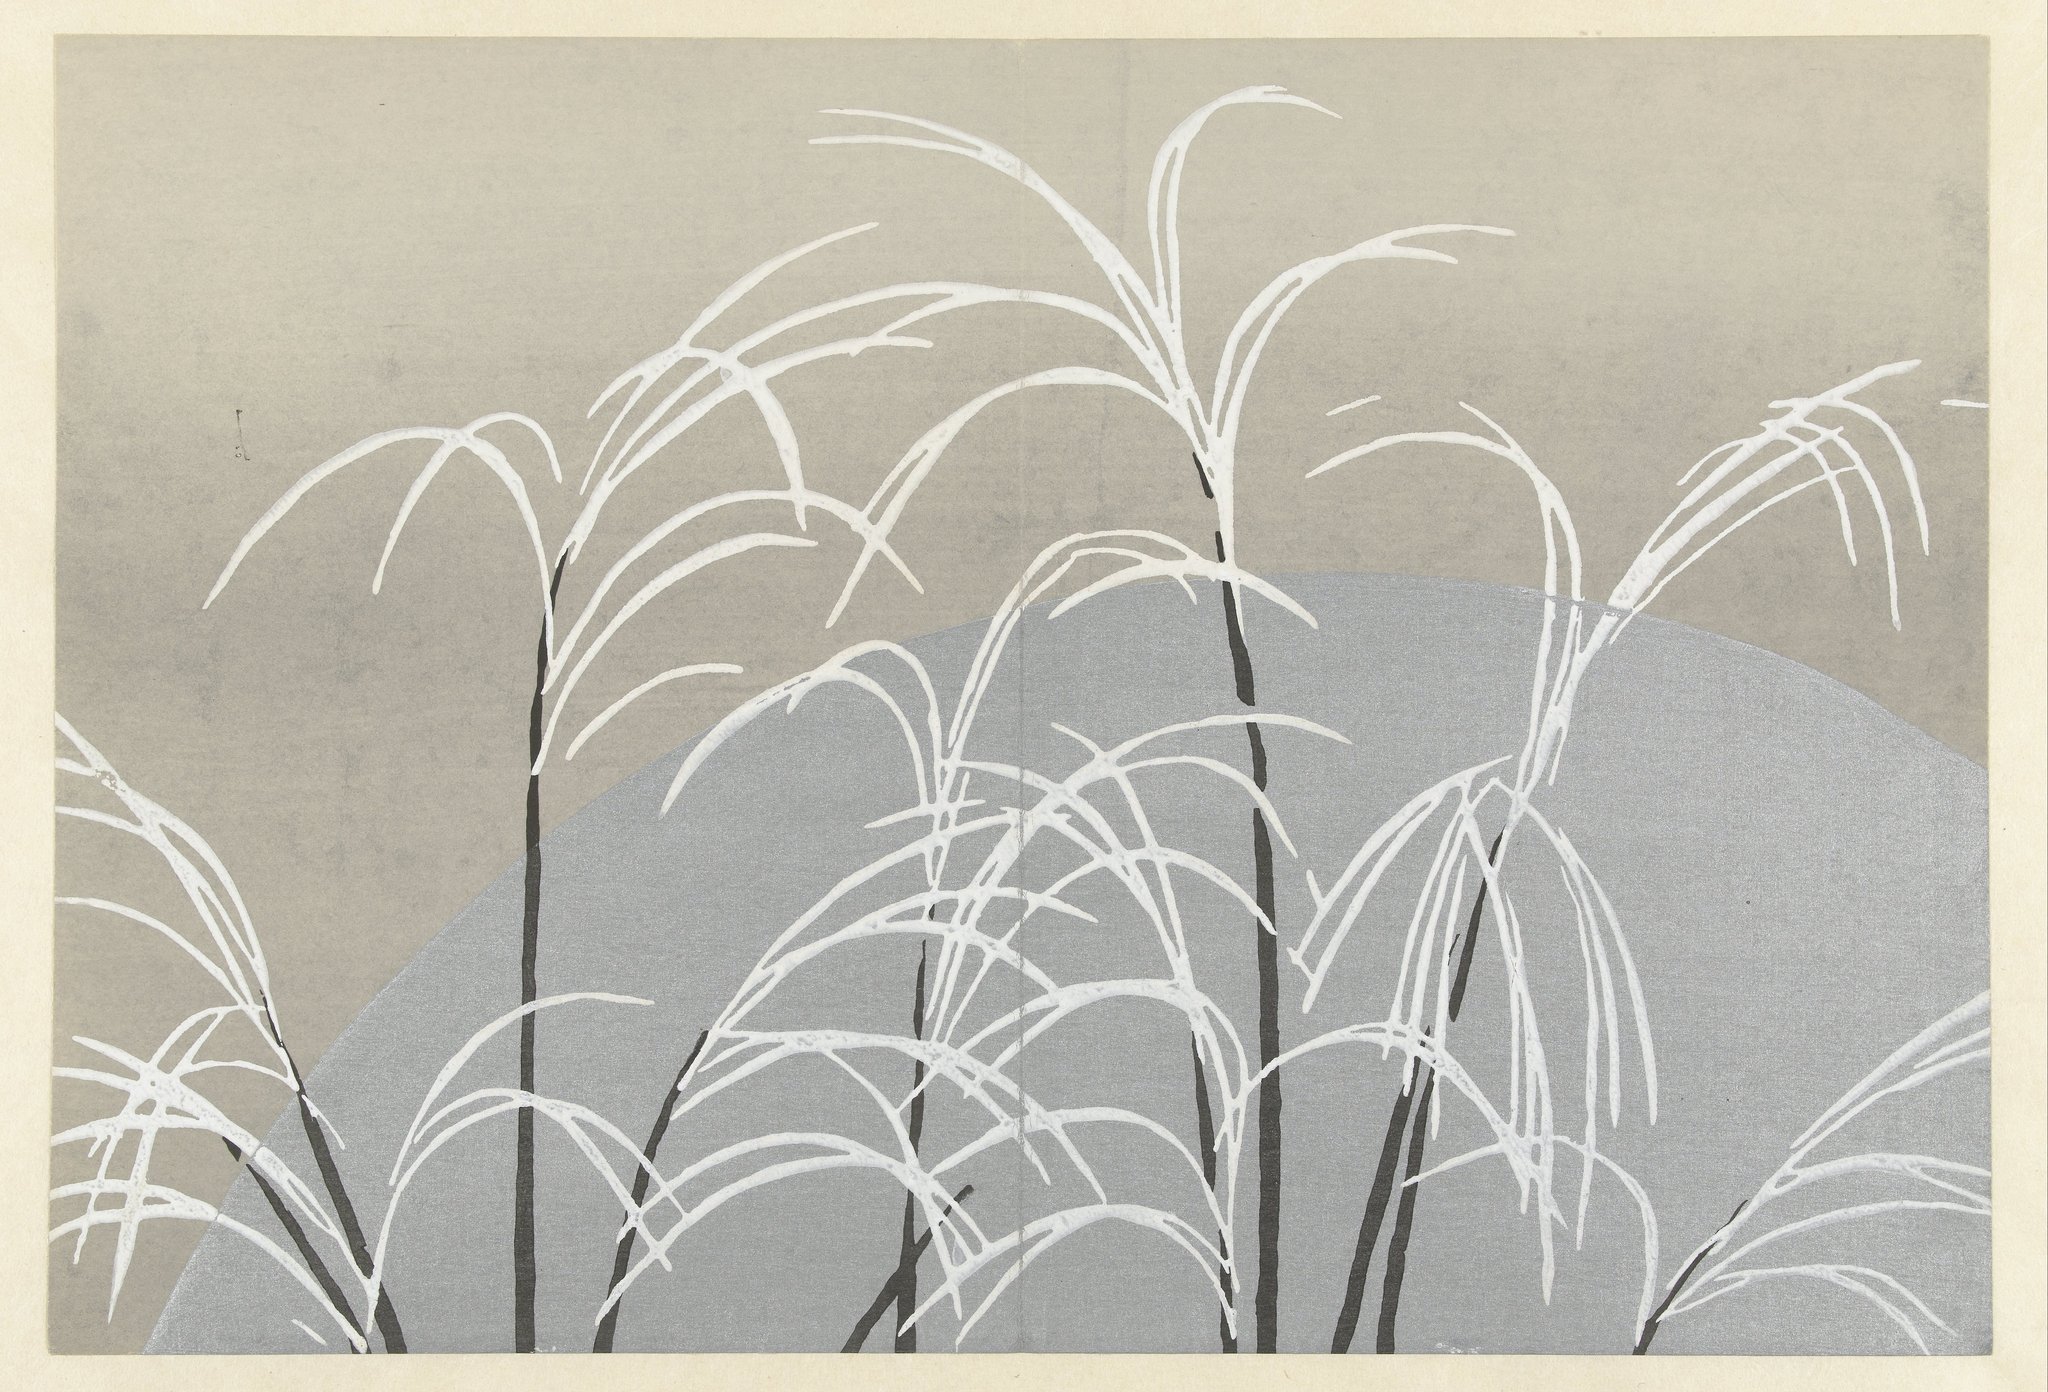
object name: print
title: Four Prints from the Series ‘Flowers of a Hundred Worlds’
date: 1909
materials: paper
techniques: woodcut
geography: kyoto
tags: plants; vegetation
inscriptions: collector's mark: Lugt 2228, collector's mark: Lugt 2760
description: The Rinpa School features stylized landscapes and motifs, with blocks of colour and in this instance without outlines. This style dates to the 17th century and was revived in a new form in the early 20th century. Sekka breathed new life into the movement. His designs profoundly influenced ceramics and lacquer in the 1900s to 1920s, especially in Kyoto.